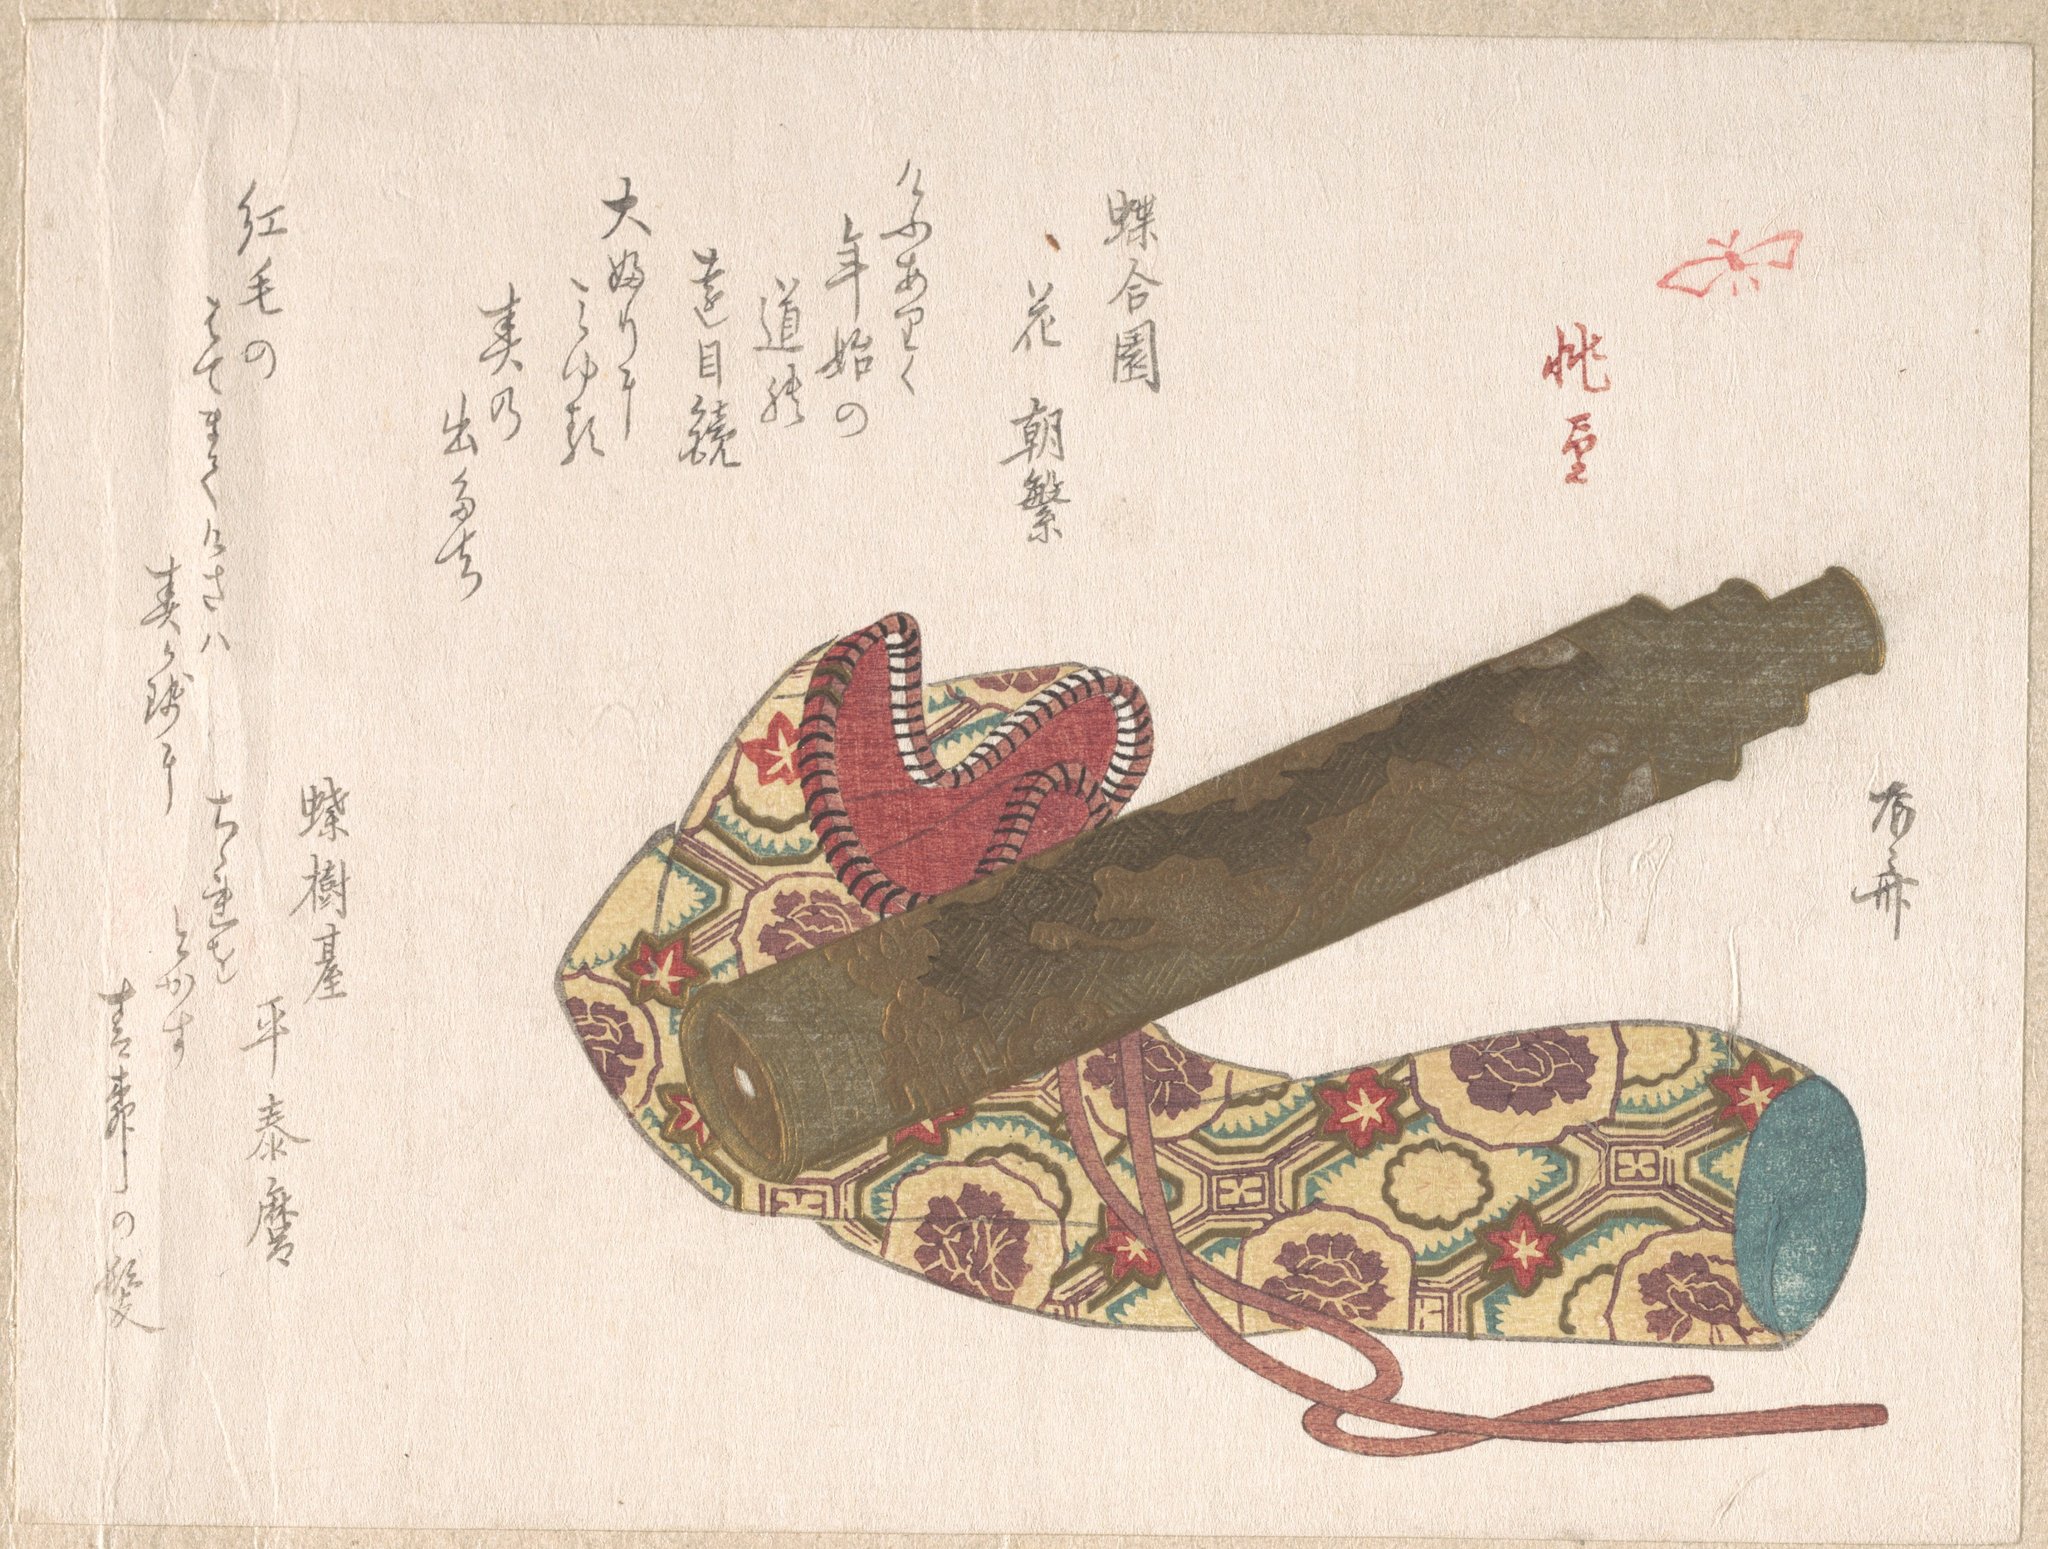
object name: print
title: Telescope with Its Bag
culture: japanese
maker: ryūryūkyo shinsai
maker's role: artist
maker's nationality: japanese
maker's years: 1799-1823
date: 1801-1900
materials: ink, paper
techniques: surimono, woodblock print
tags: telescopes